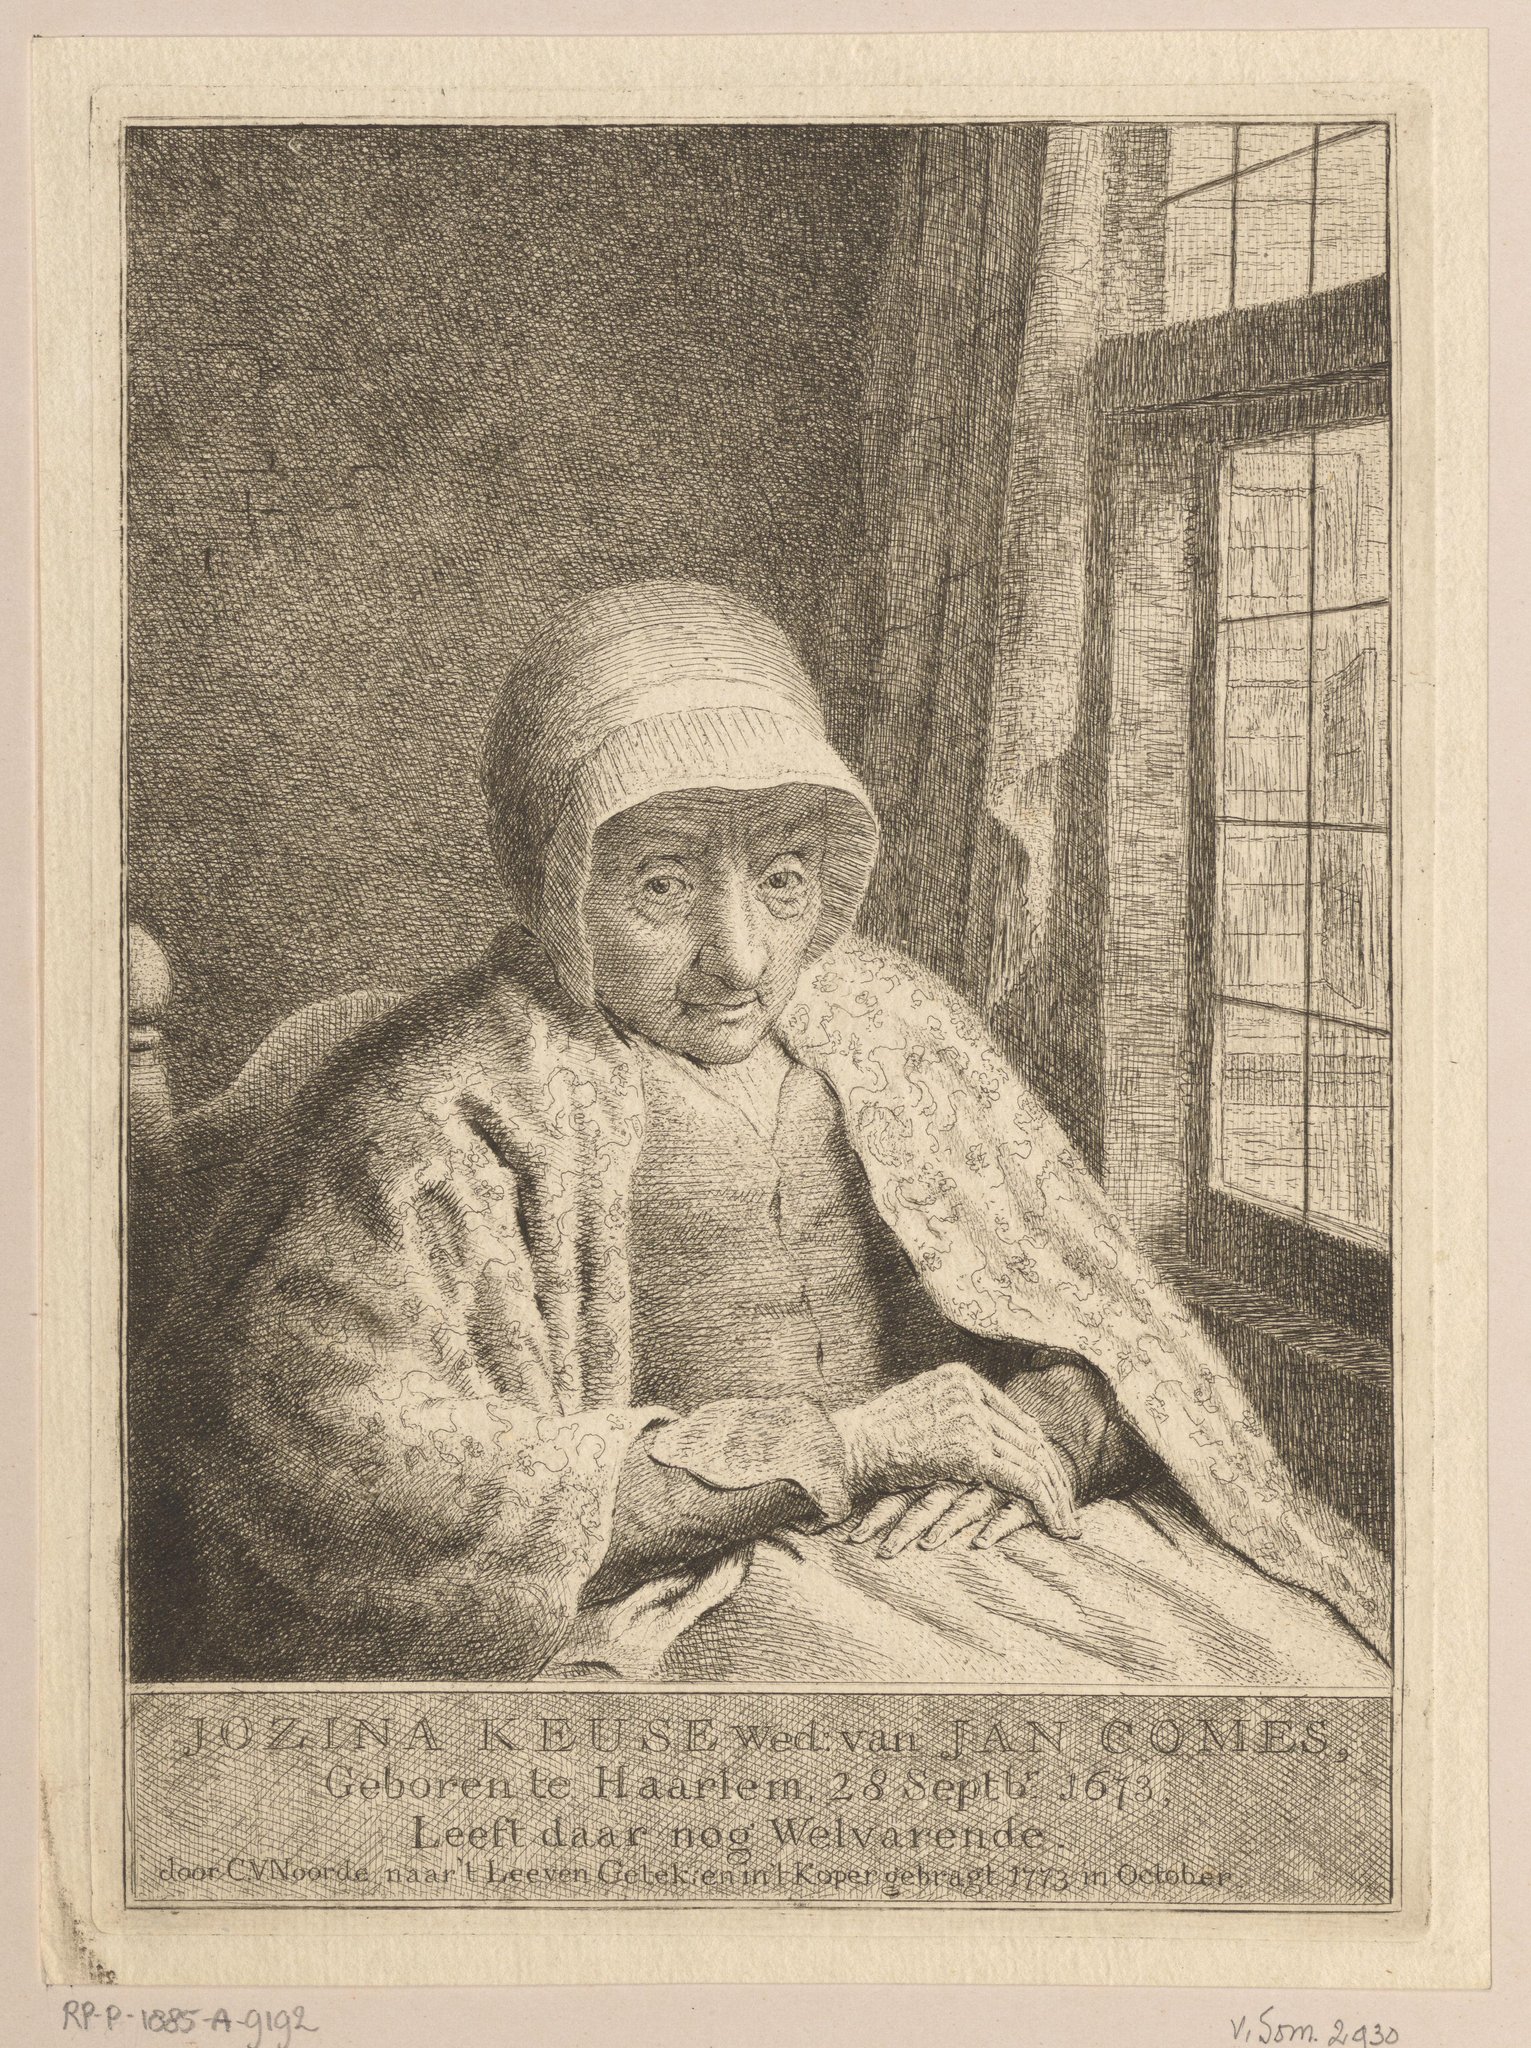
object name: print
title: Portret van Jozina Keuse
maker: cornelis van noorde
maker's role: draughtsman, print maker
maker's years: 1731-1795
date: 1773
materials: paper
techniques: etching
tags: historical persons - bb - woman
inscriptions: collector's mark: Lugt 2228